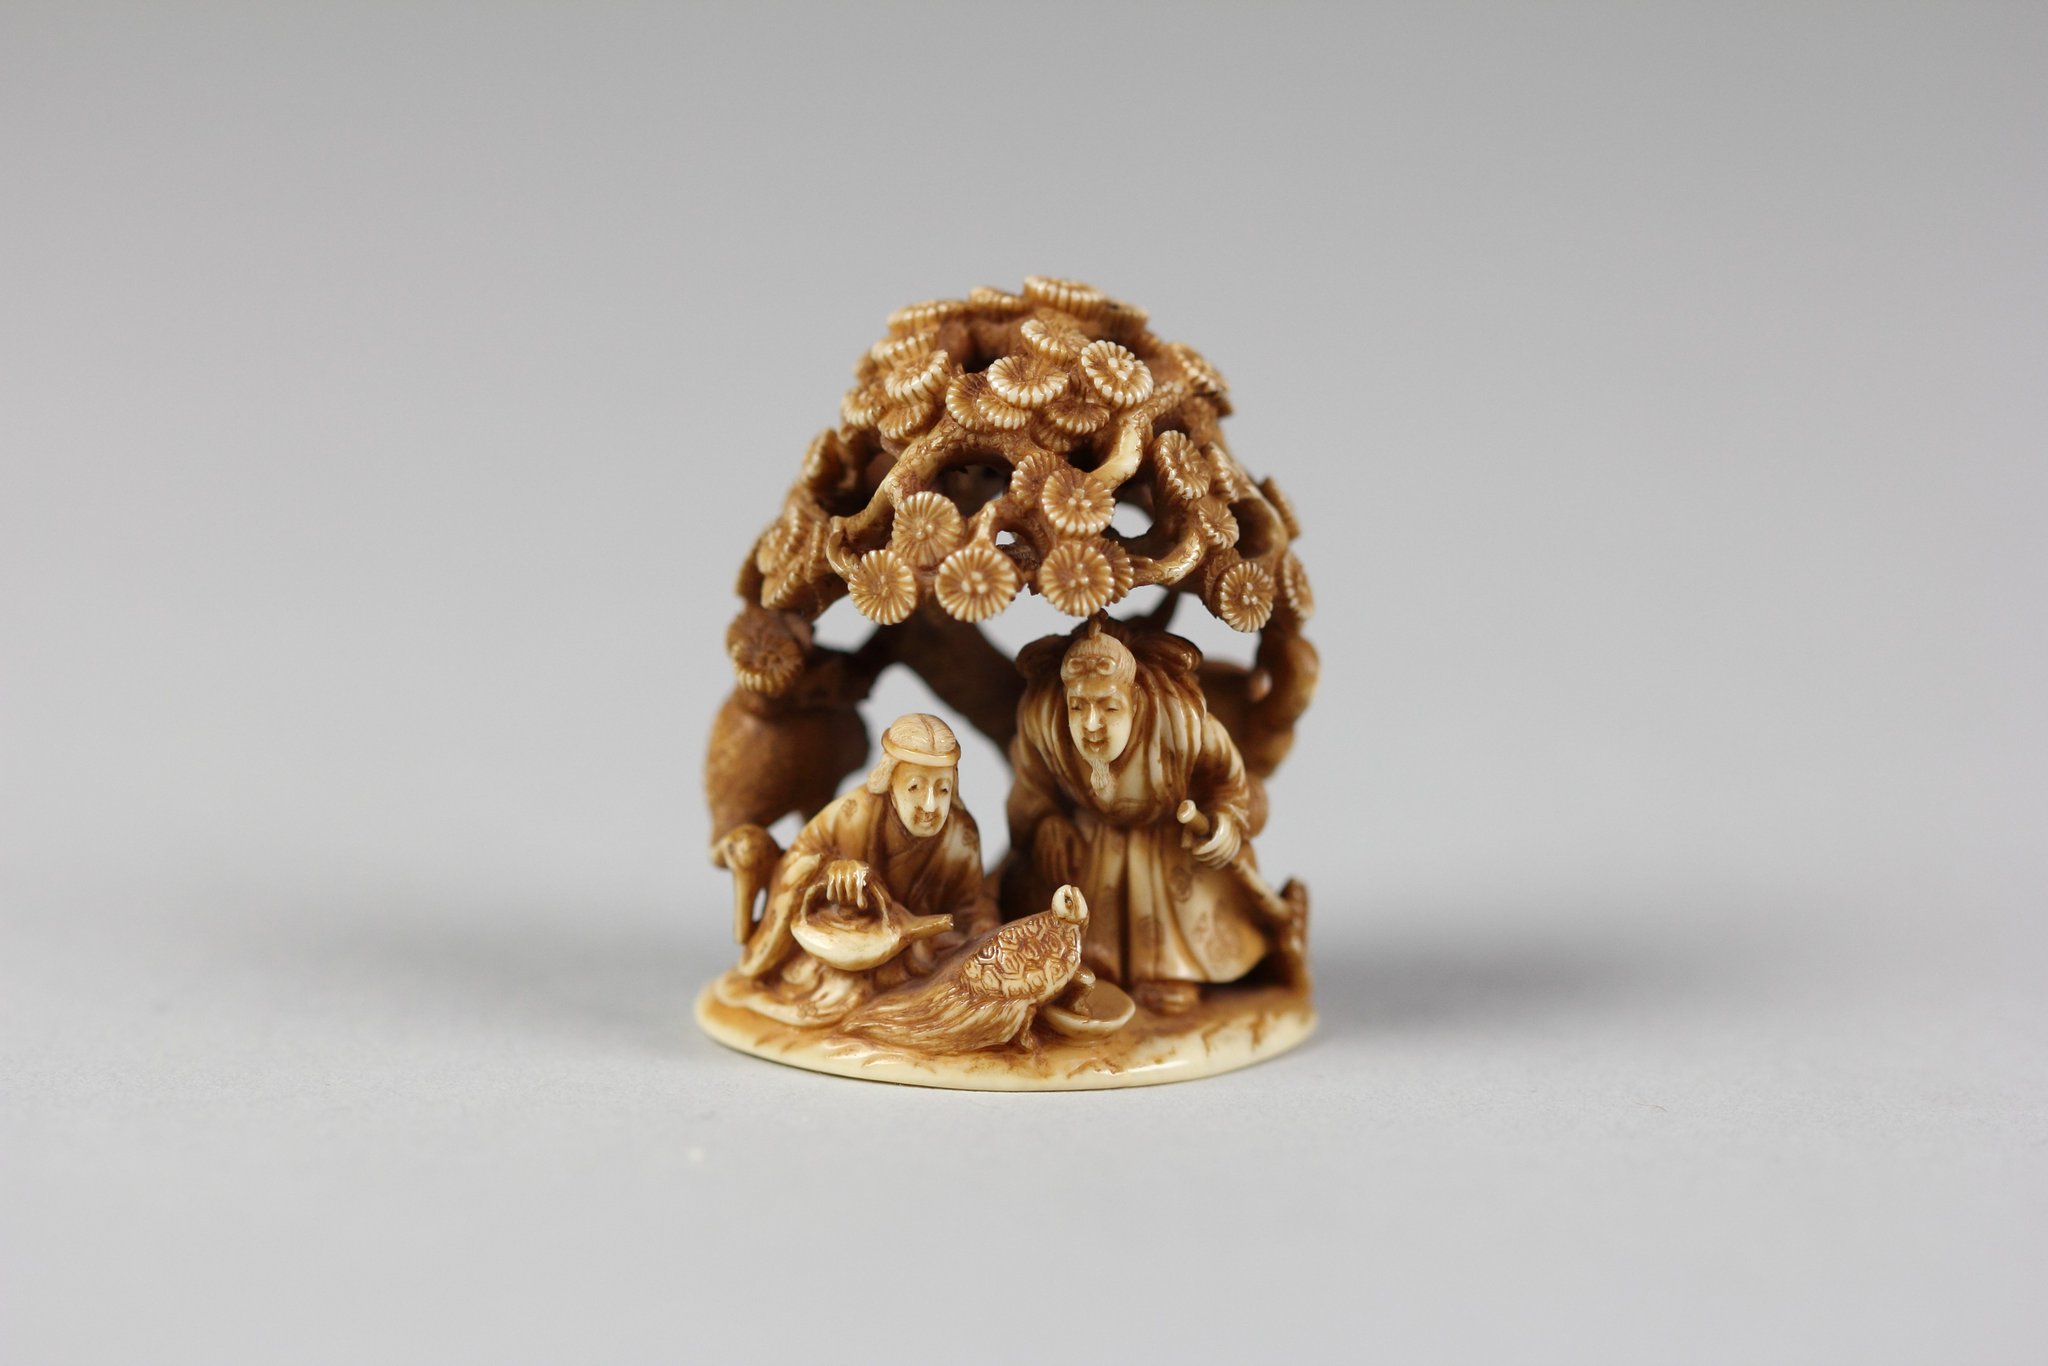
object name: netsuke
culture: japanese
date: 1801-1900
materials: ivory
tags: birds,men